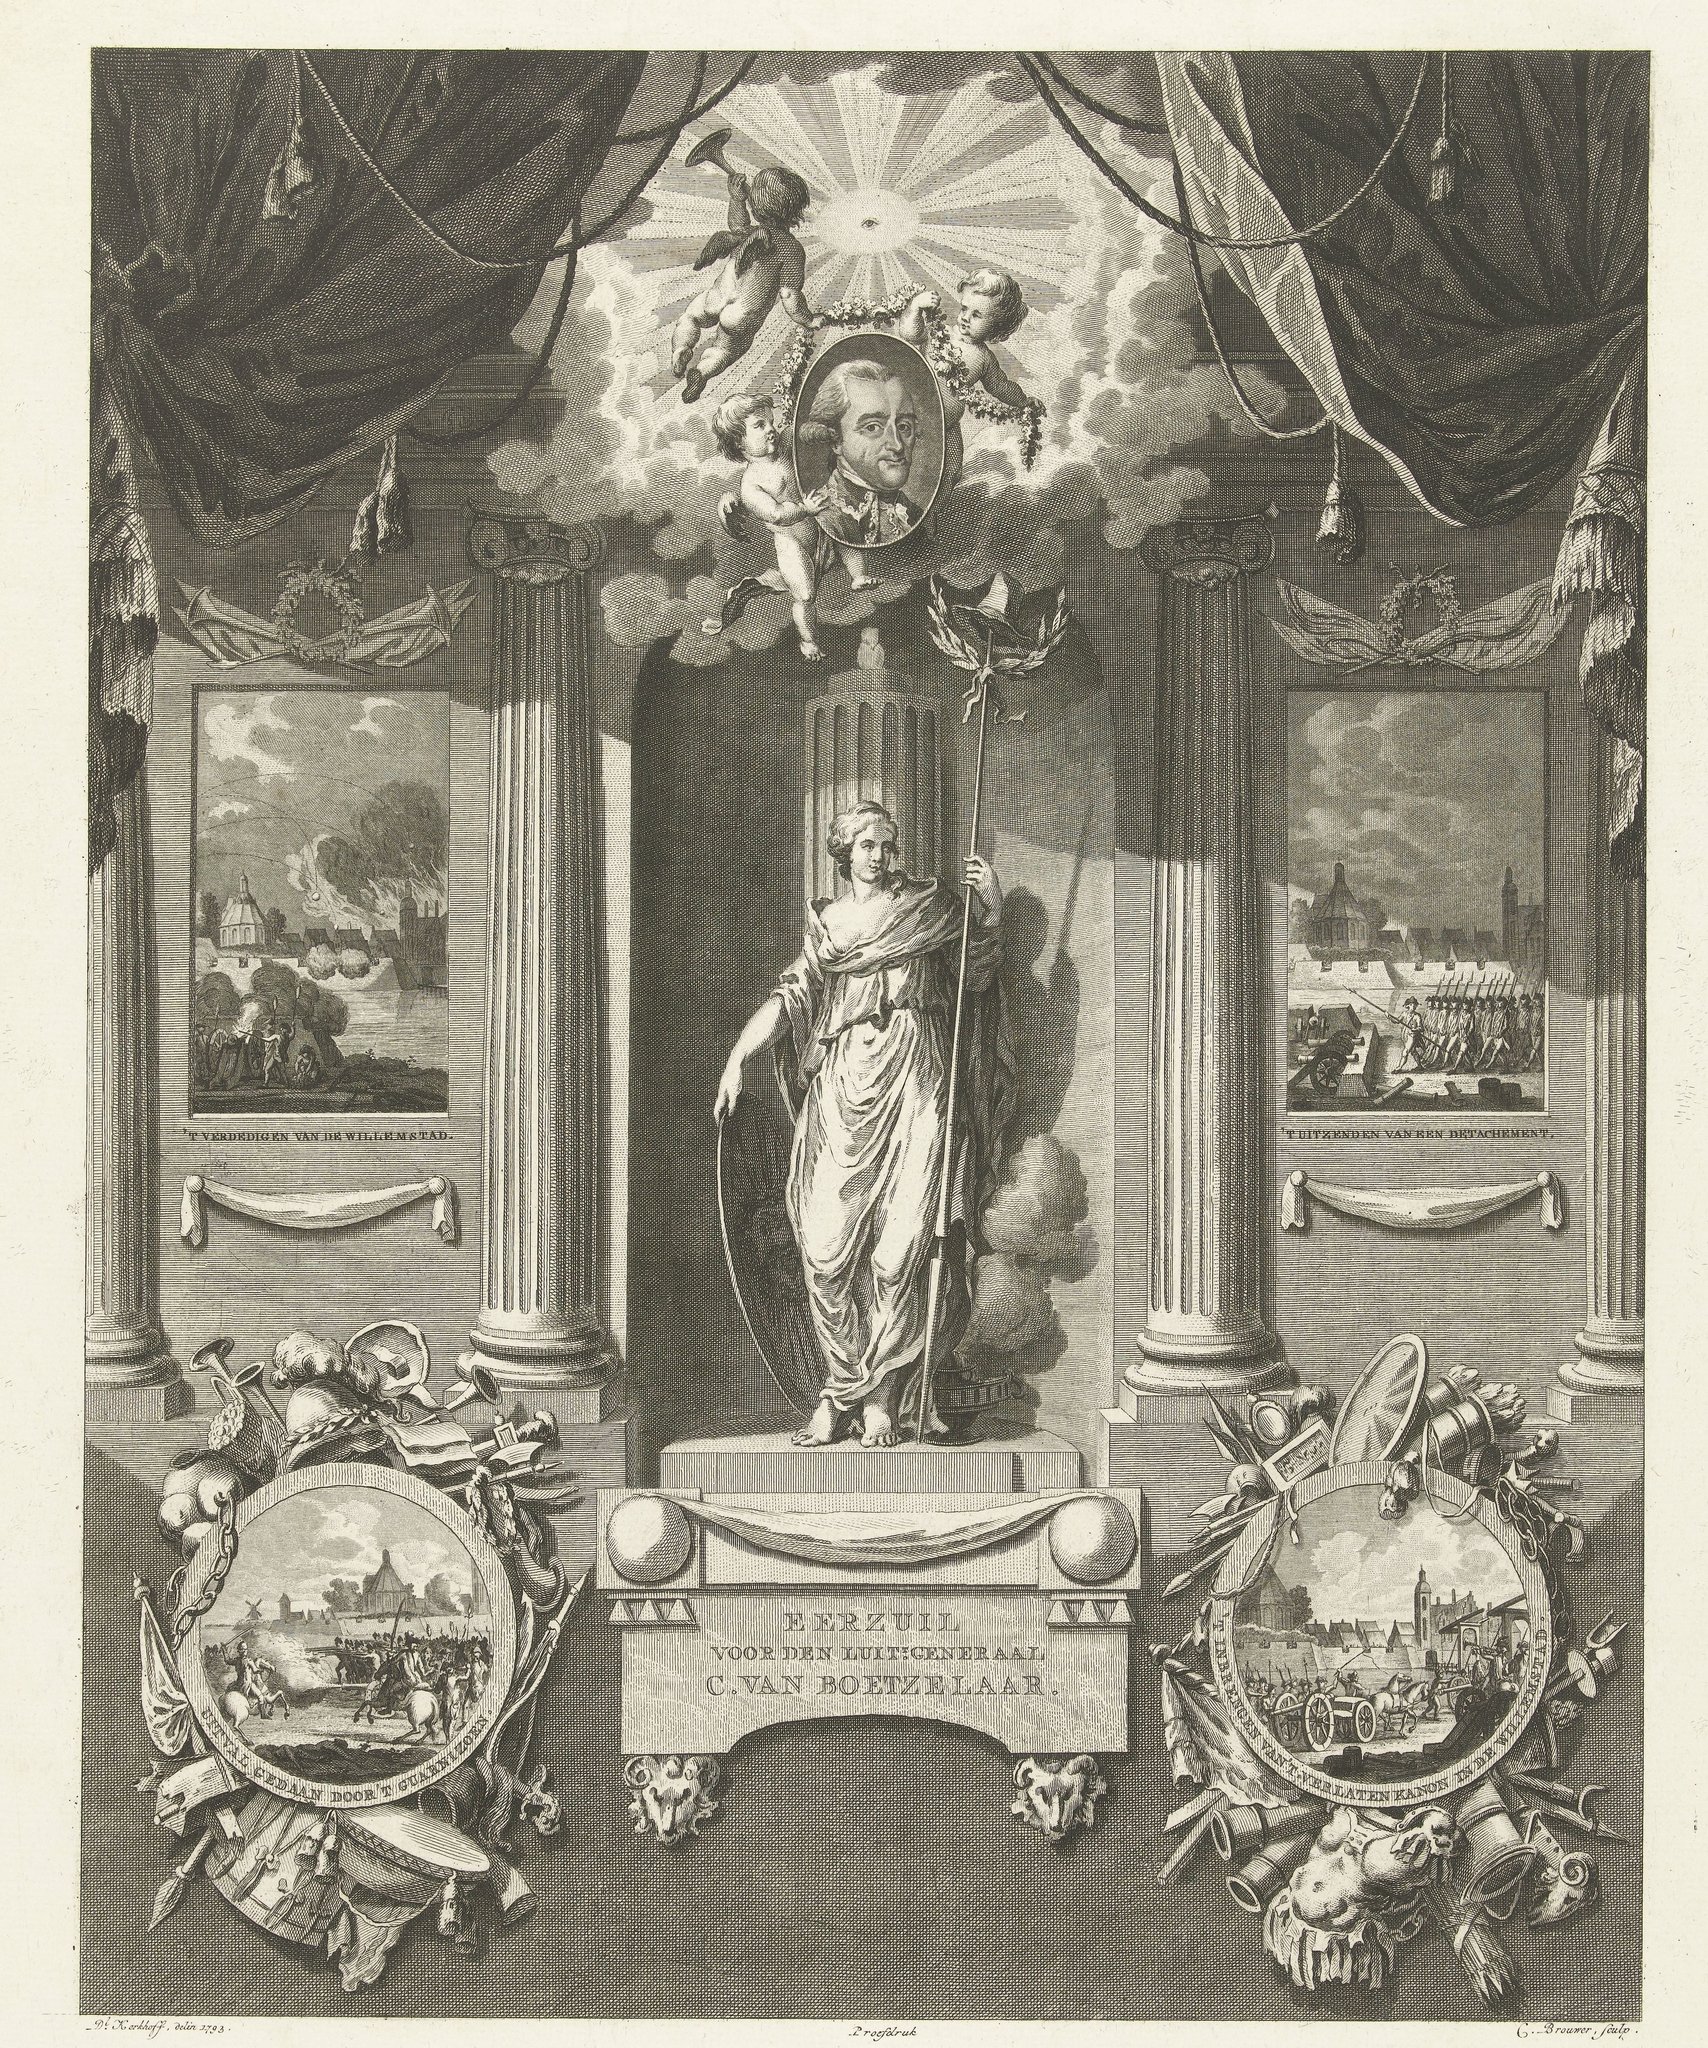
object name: print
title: Monument voor Carel van Boetzelaer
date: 1793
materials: paper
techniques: engraving, etching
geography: netherlands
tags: the hague, monument, statue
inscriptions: collector's mark: Lugt 2228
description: Monument ter ere van gouverneur Carel van Boetzelaer met vier scènes van gebeurtenissen die zich afspeelden tijdens zijn succesvolle verdediging van Willemstad tegen de Fransen op 15 maart 1793. De scènes flankeren een zuil met eretekens bekroond met medaillon met zijn portret en tonen de verdediging van Willemstad.